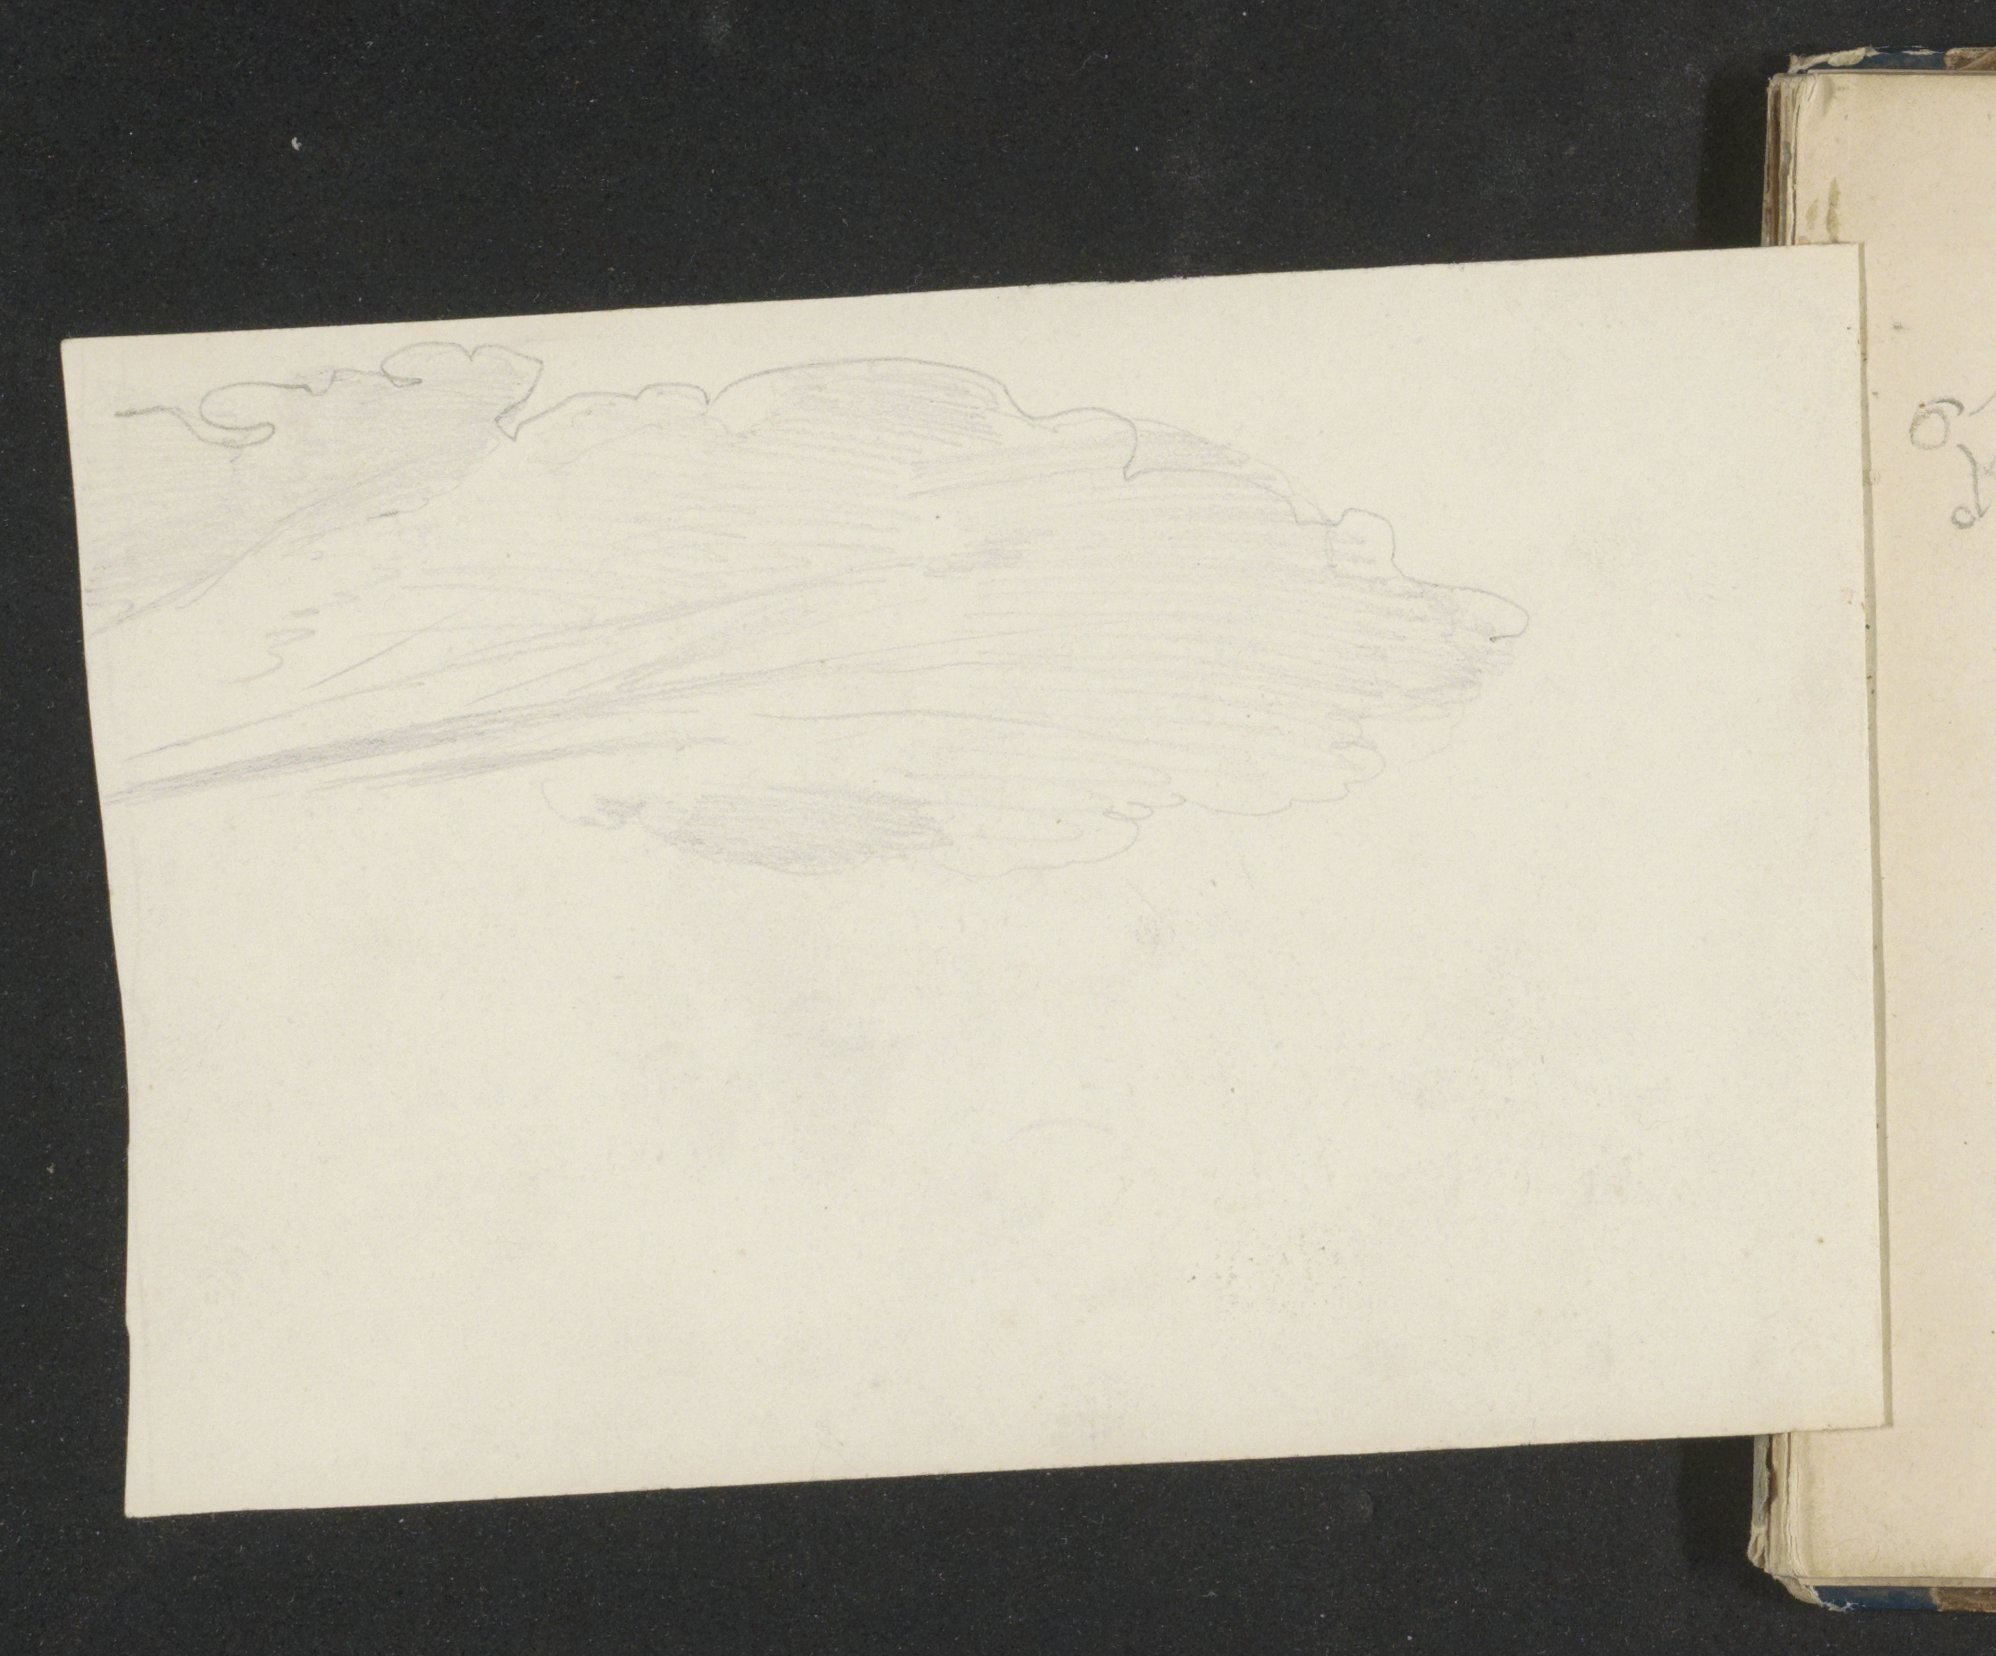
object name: sketchbook leaf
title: Boom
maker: Anonymous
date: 1841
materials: paper, pencil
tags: trees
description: Blad 1 verso uit een schetsboek met 33 bladen.